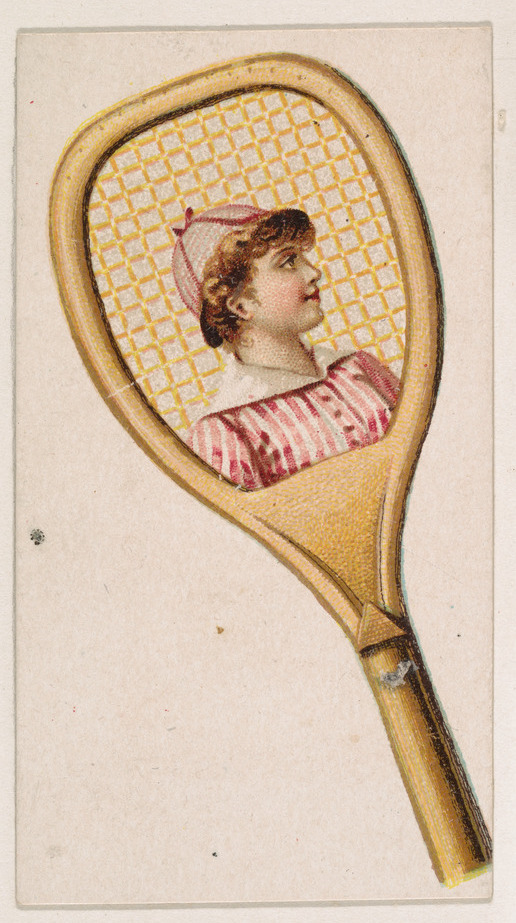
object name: print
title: Tennis Racket, from the Novelties series (N228, Type 5) issued by Kinney Bros.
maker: kinney brothers tobacco company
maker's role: publisher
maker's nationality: american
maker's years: 1869-2011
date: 1889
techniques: color lithograph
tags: women,tennis